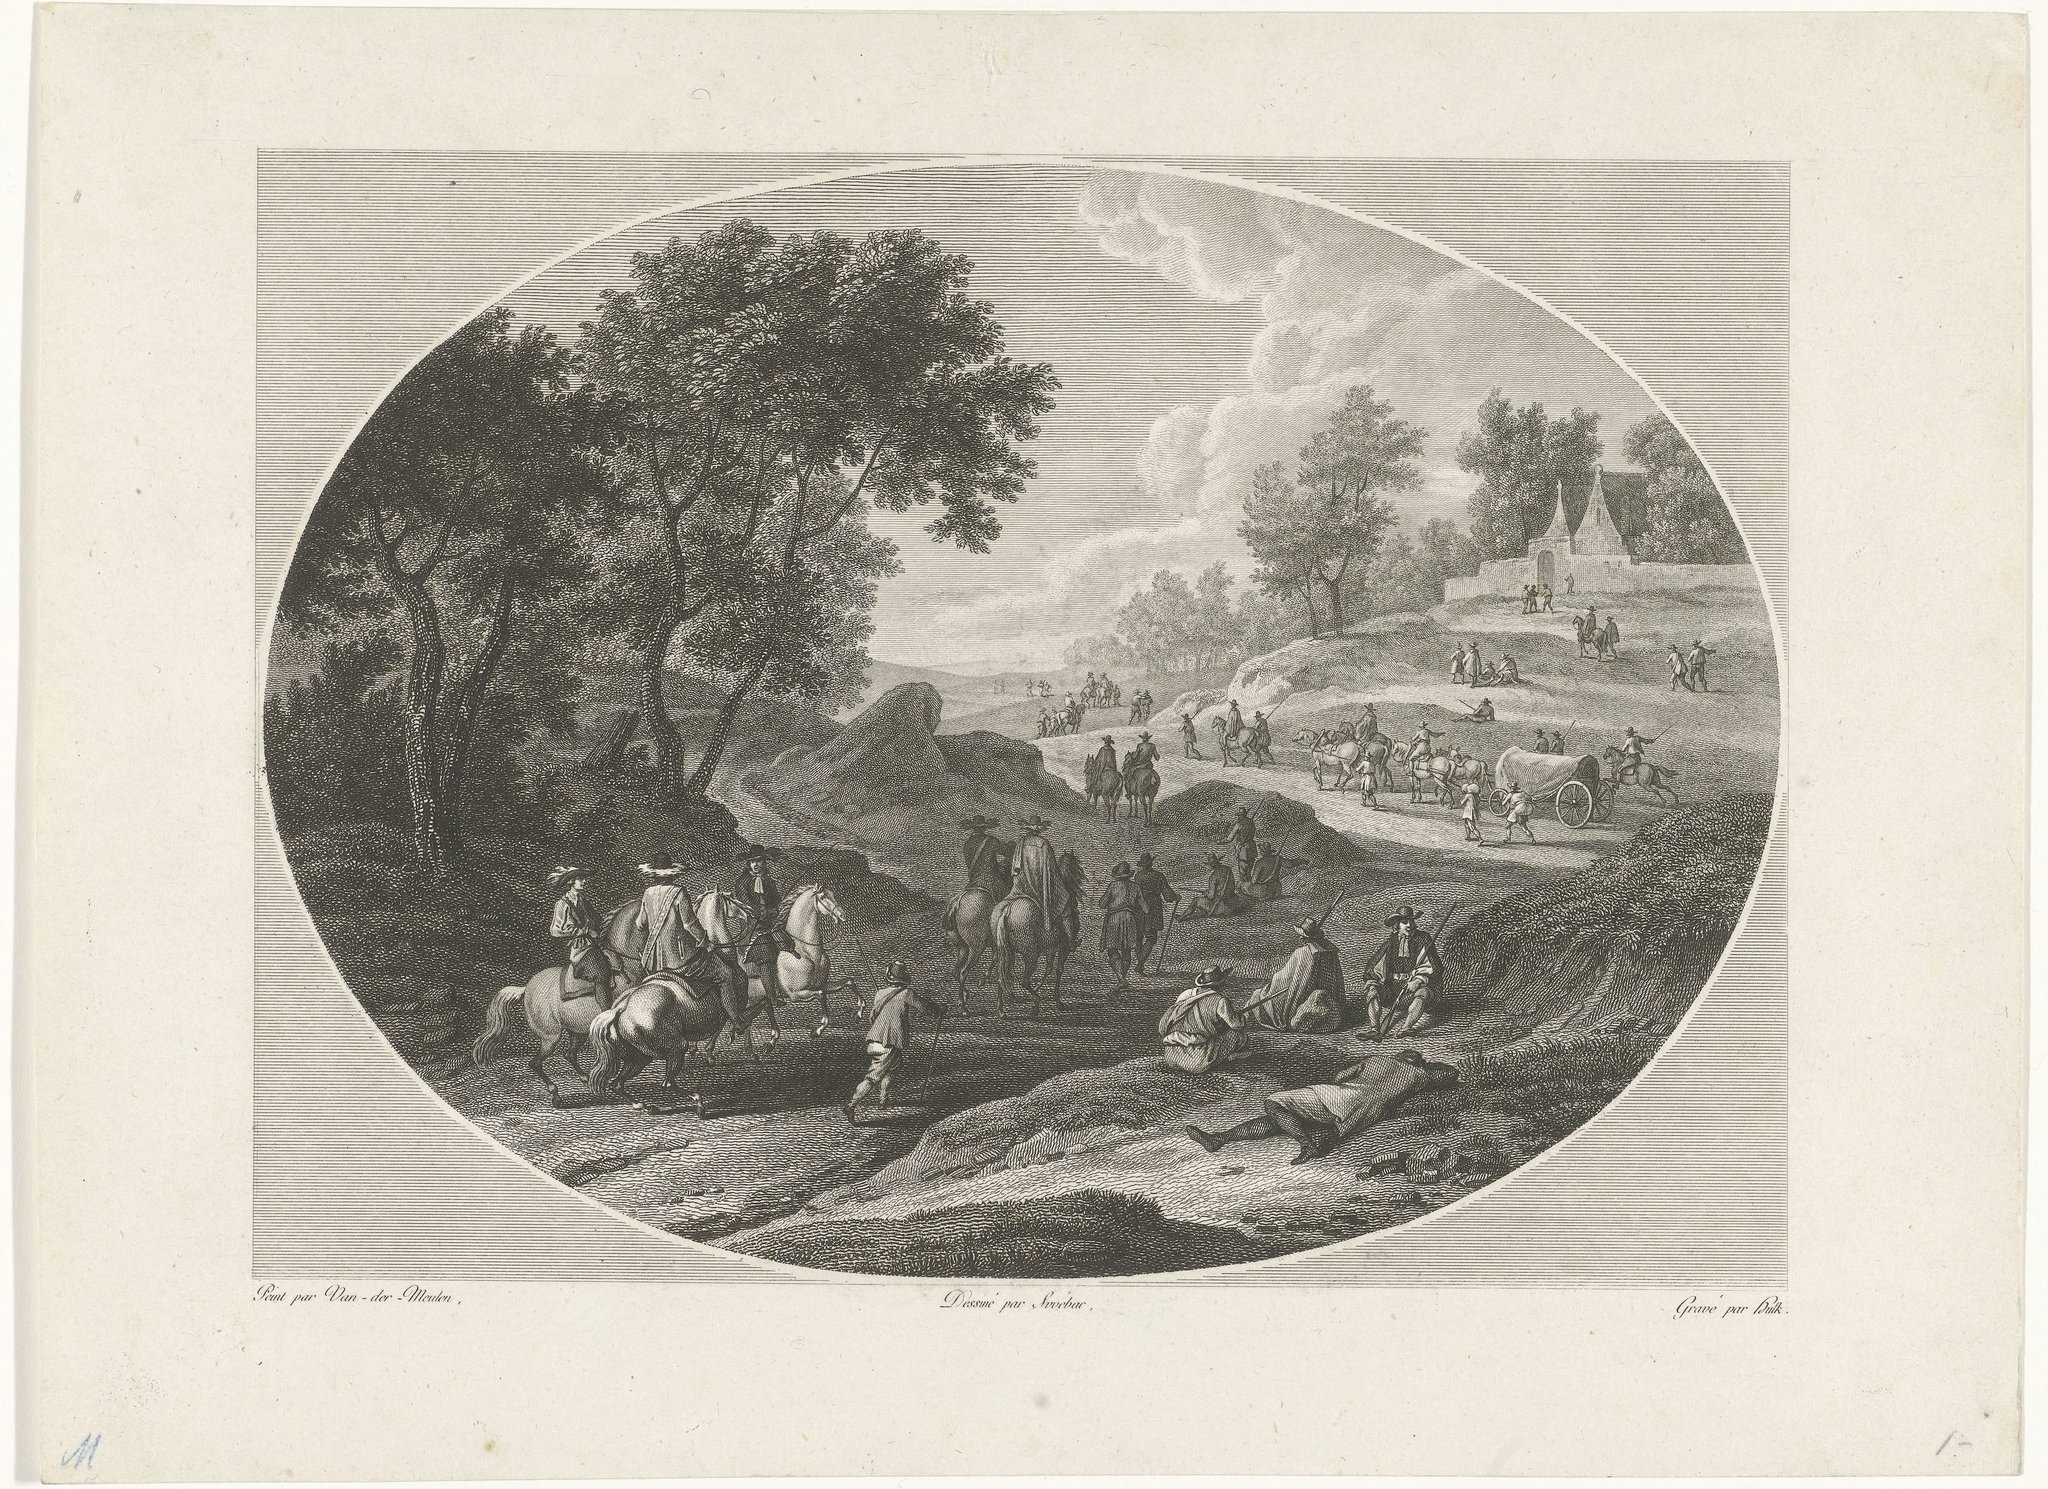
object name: print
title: Landschap met ruiters en wandelaars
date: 1766-1817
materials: paper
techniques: engraving, etching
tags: riding a horse, ass, or mule; rider, horseman, landscapes (+ landscape with figures, staffage)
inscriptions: collector's mark: Lugt 1731, inscription: ‘M’, collector's mark: Lugt 2228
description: Links ruiters voor enkele bomen. Op de voorgrond vier rustende figuren. Een weg met daarop ruiters, een rijtuig en wandelaars slingert naar de horizon. Rechts een huis en een poort.